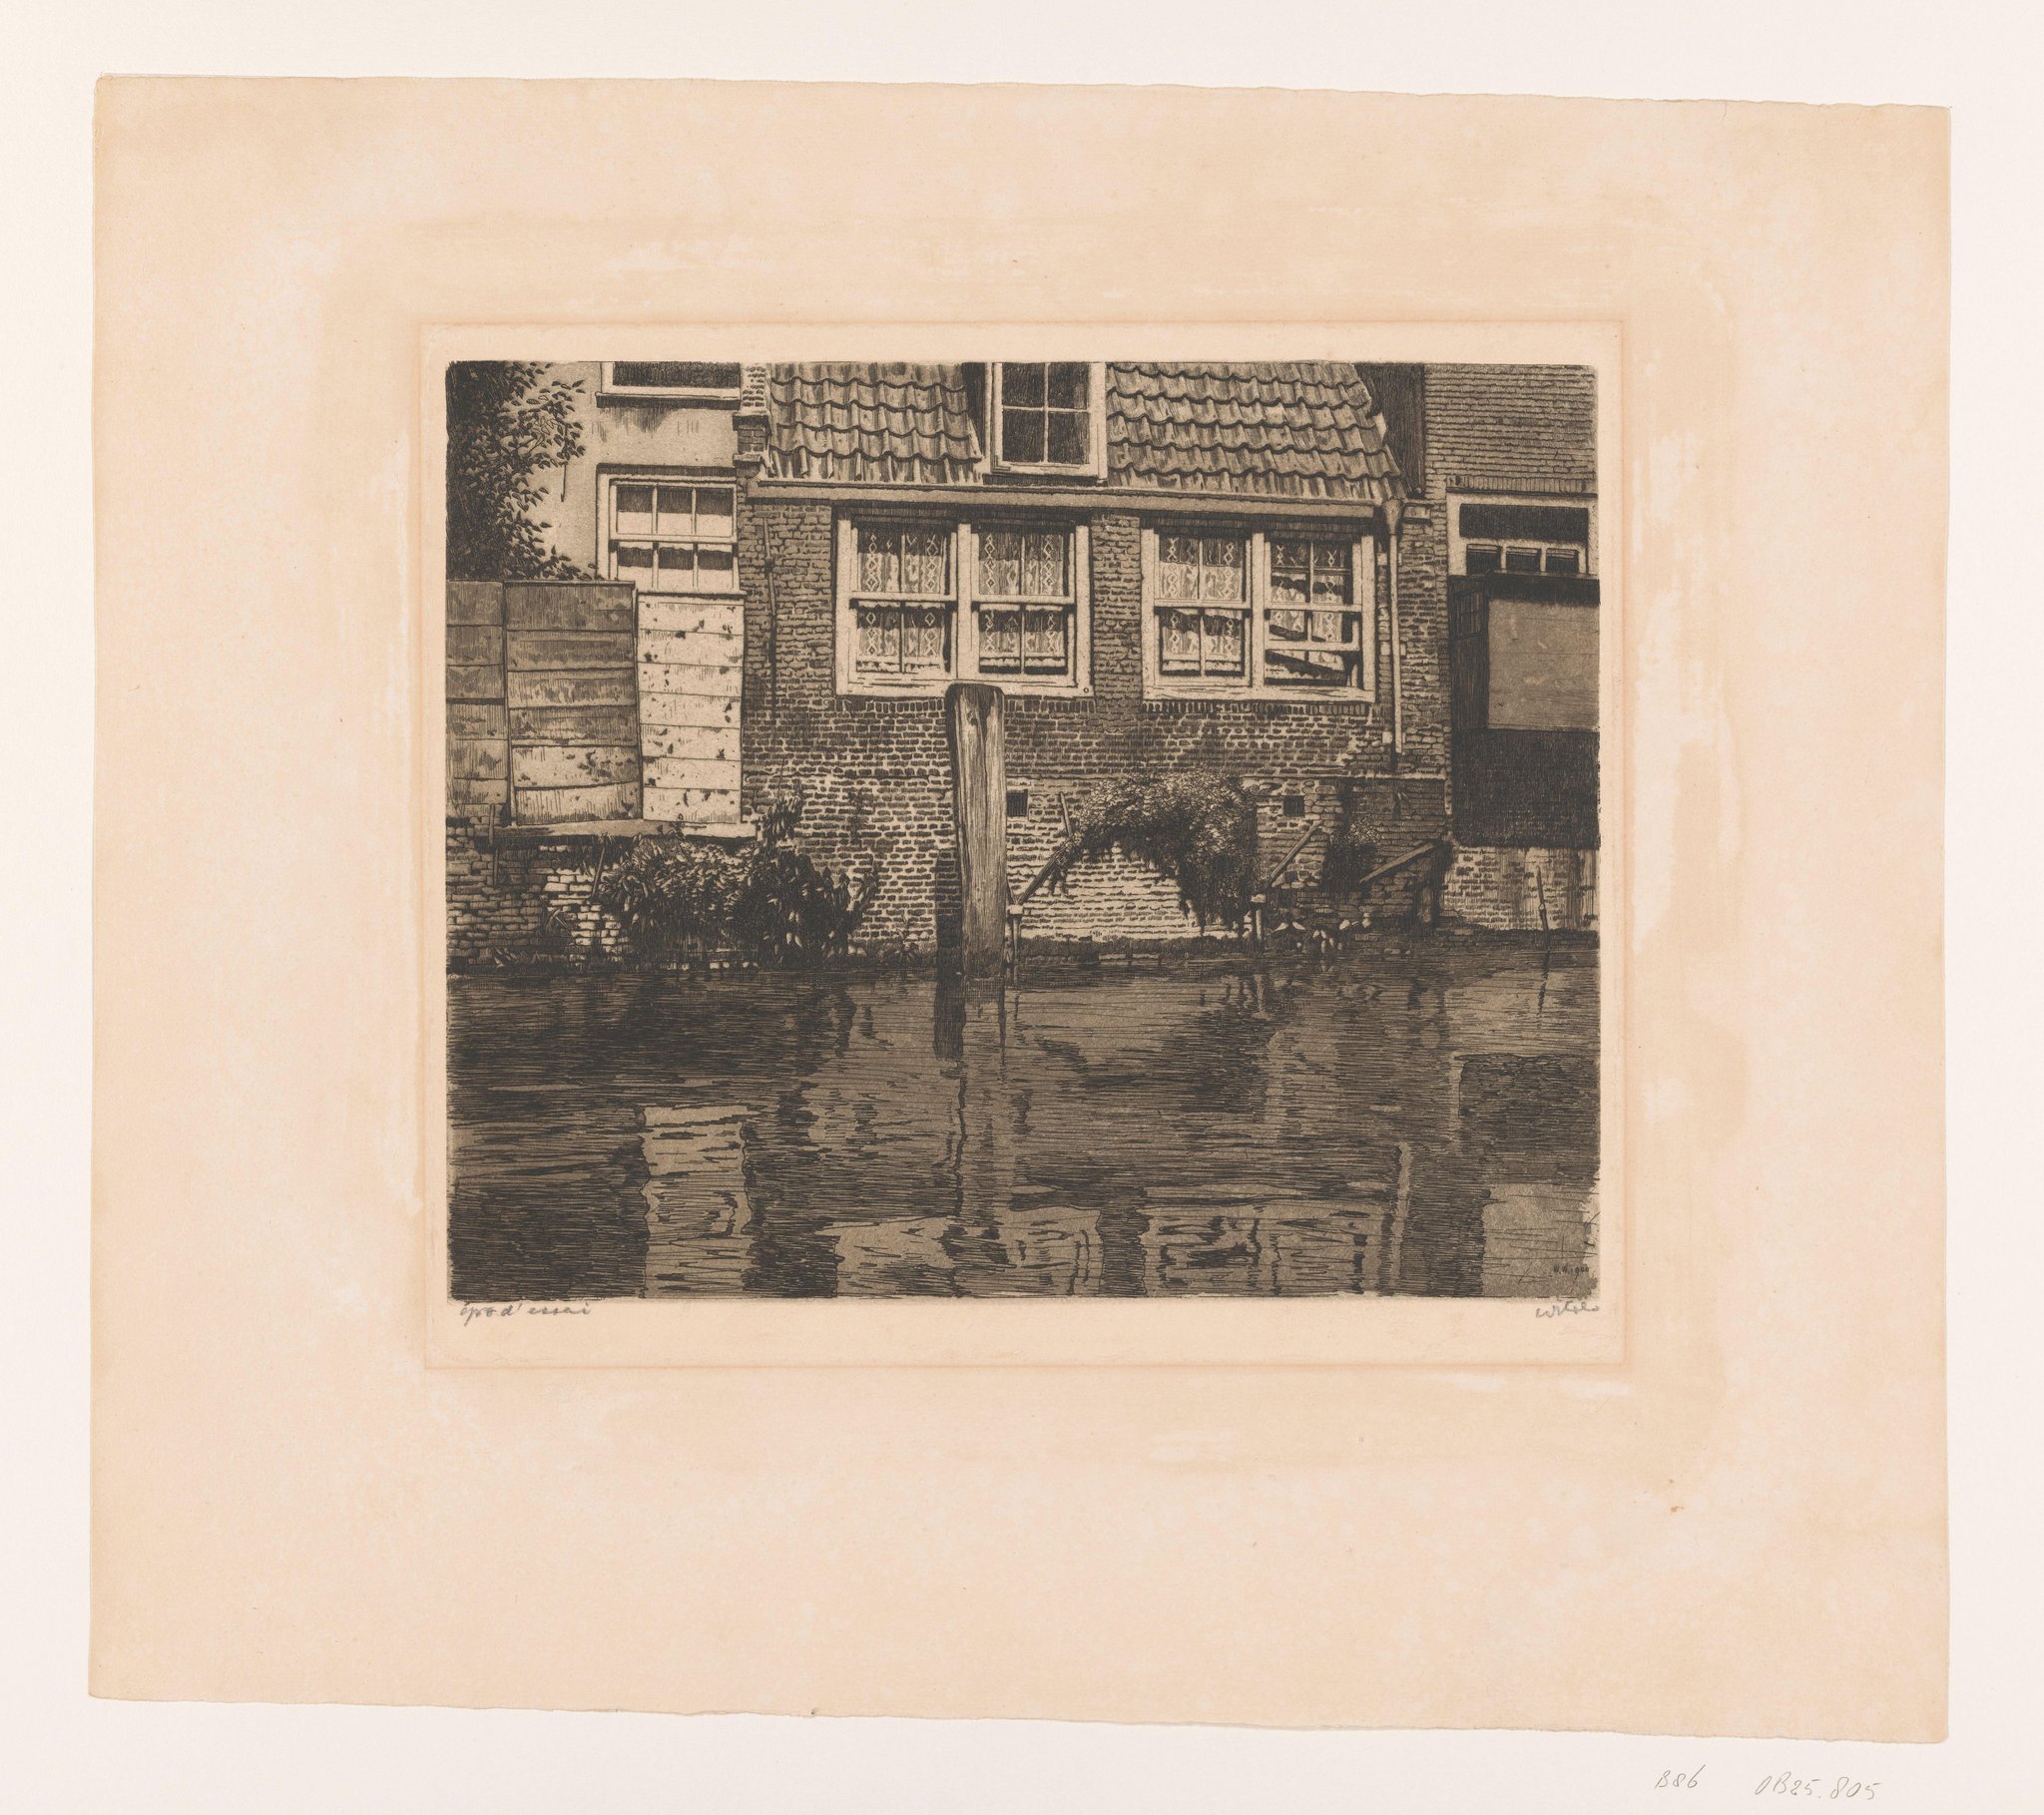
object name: print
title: Achtergevels van de Grotekerksbuurt 10, 8 en 6 te Dordrecht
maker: willem witsen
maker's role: draughtsman, painter, print maker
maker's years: 1860-1923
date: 1900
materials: paper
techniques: aquatint, etching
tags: harbour, city-view in general; 'veduta', canals, waters (in city), dordrecht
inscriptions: collector's mark: Lugt 2228, annotation: ‘épr. d'essai’